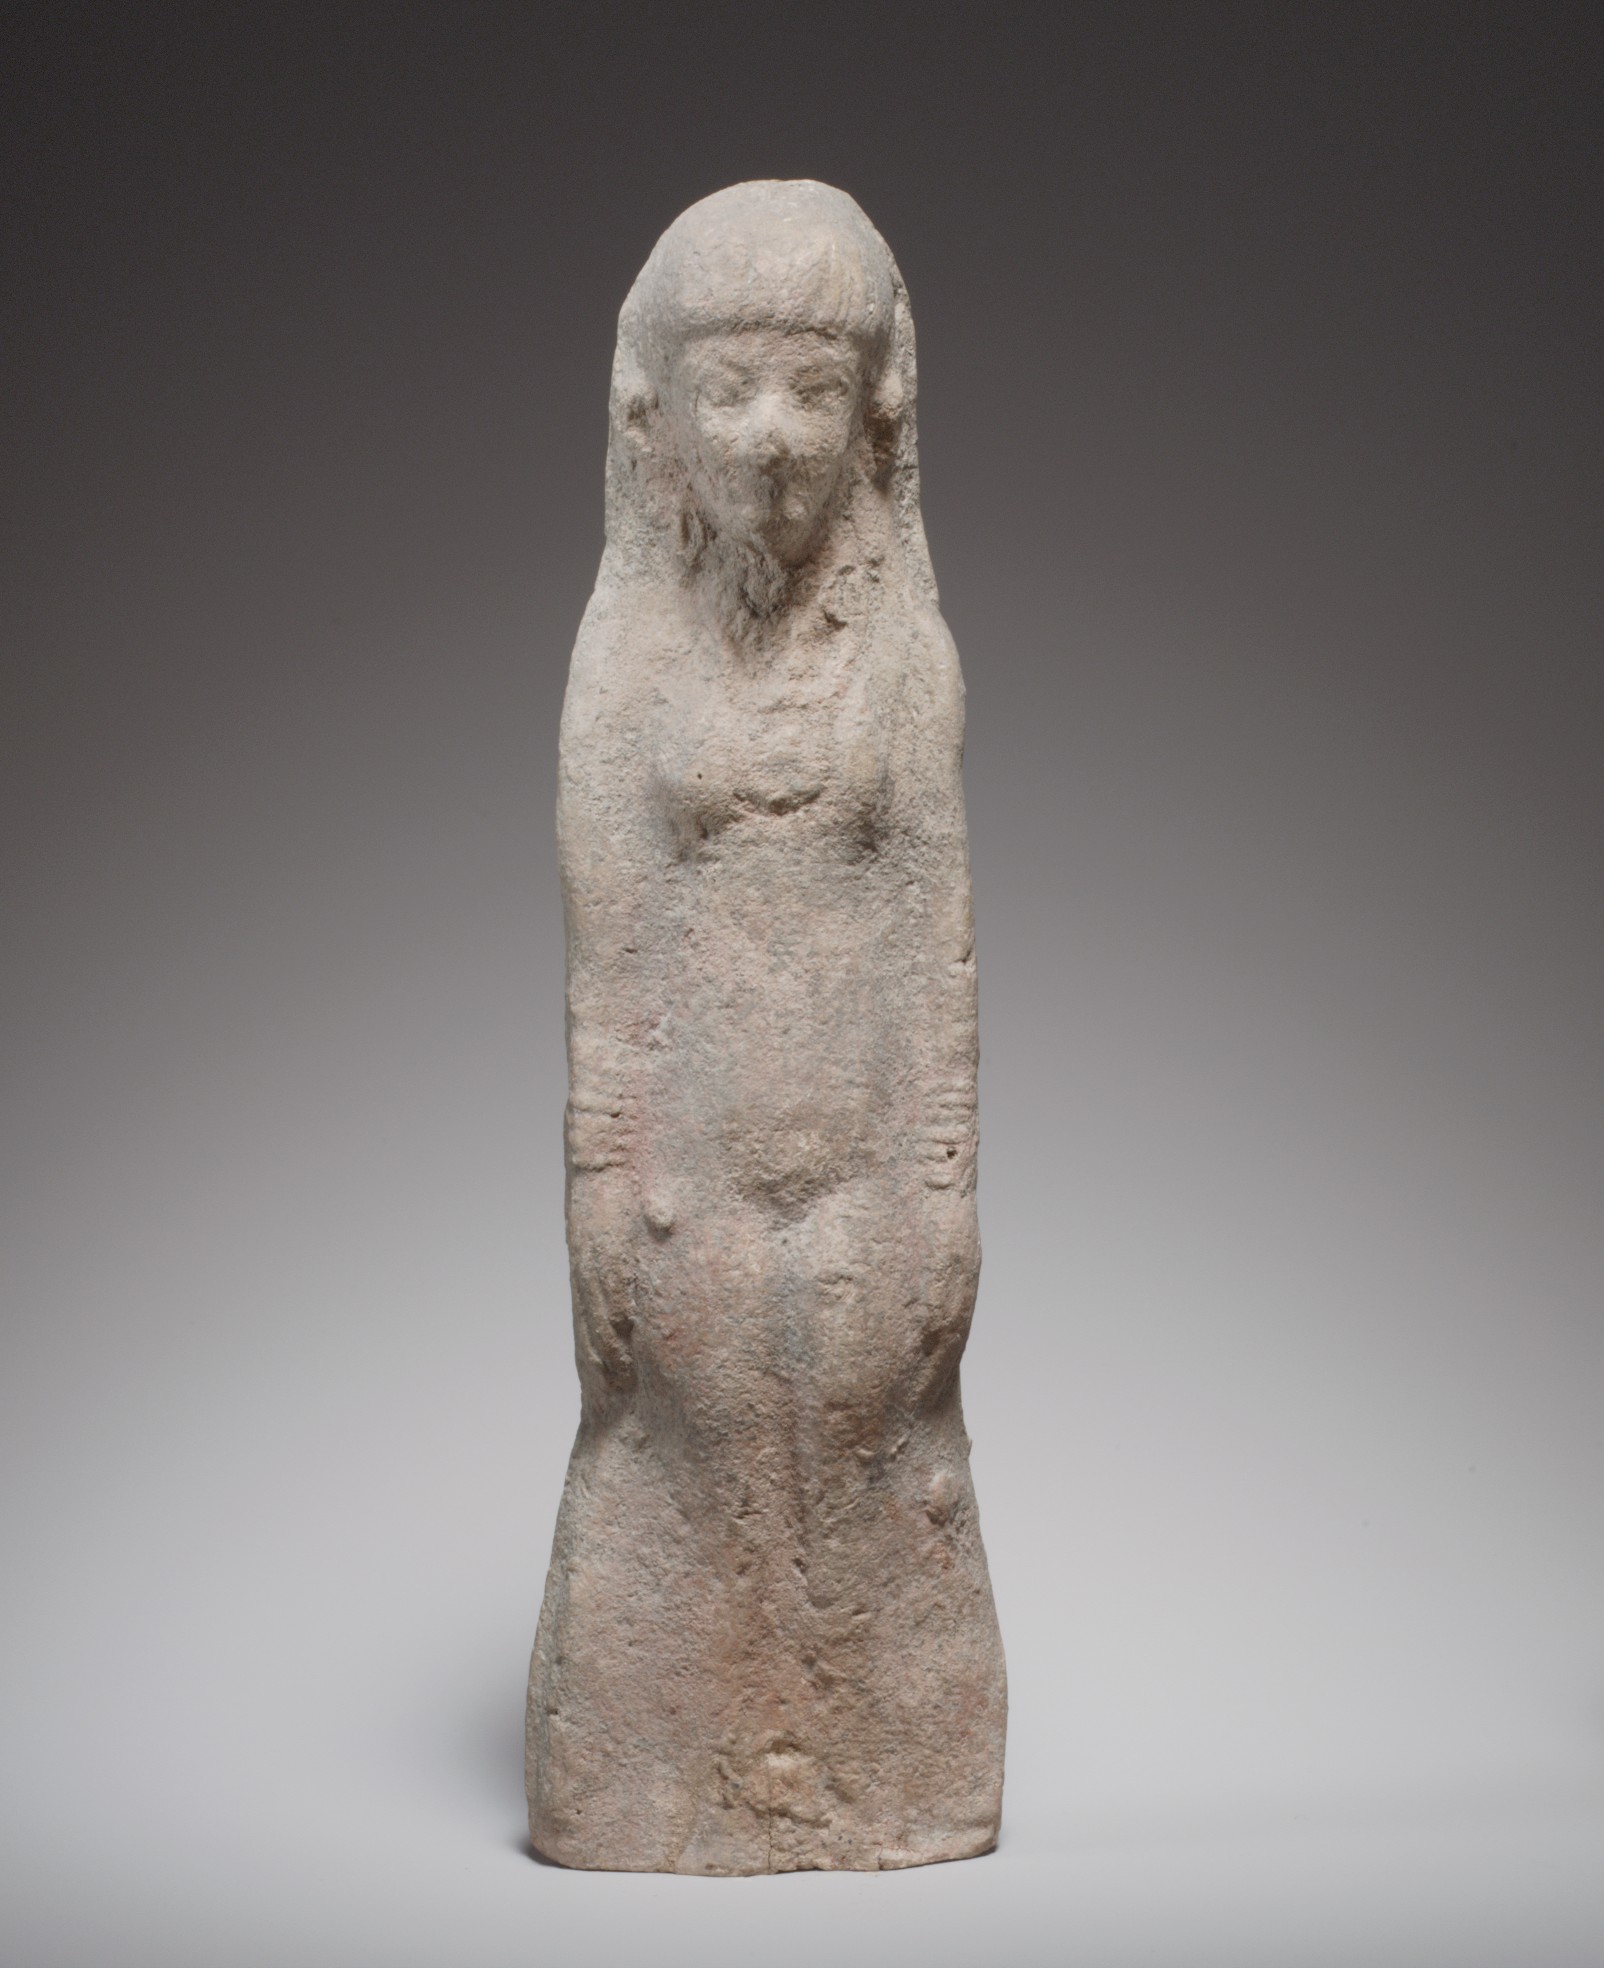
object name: statuette of a woman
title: Standing female figurine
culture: cypriot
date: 600-480 BCE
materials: terracotta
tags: women